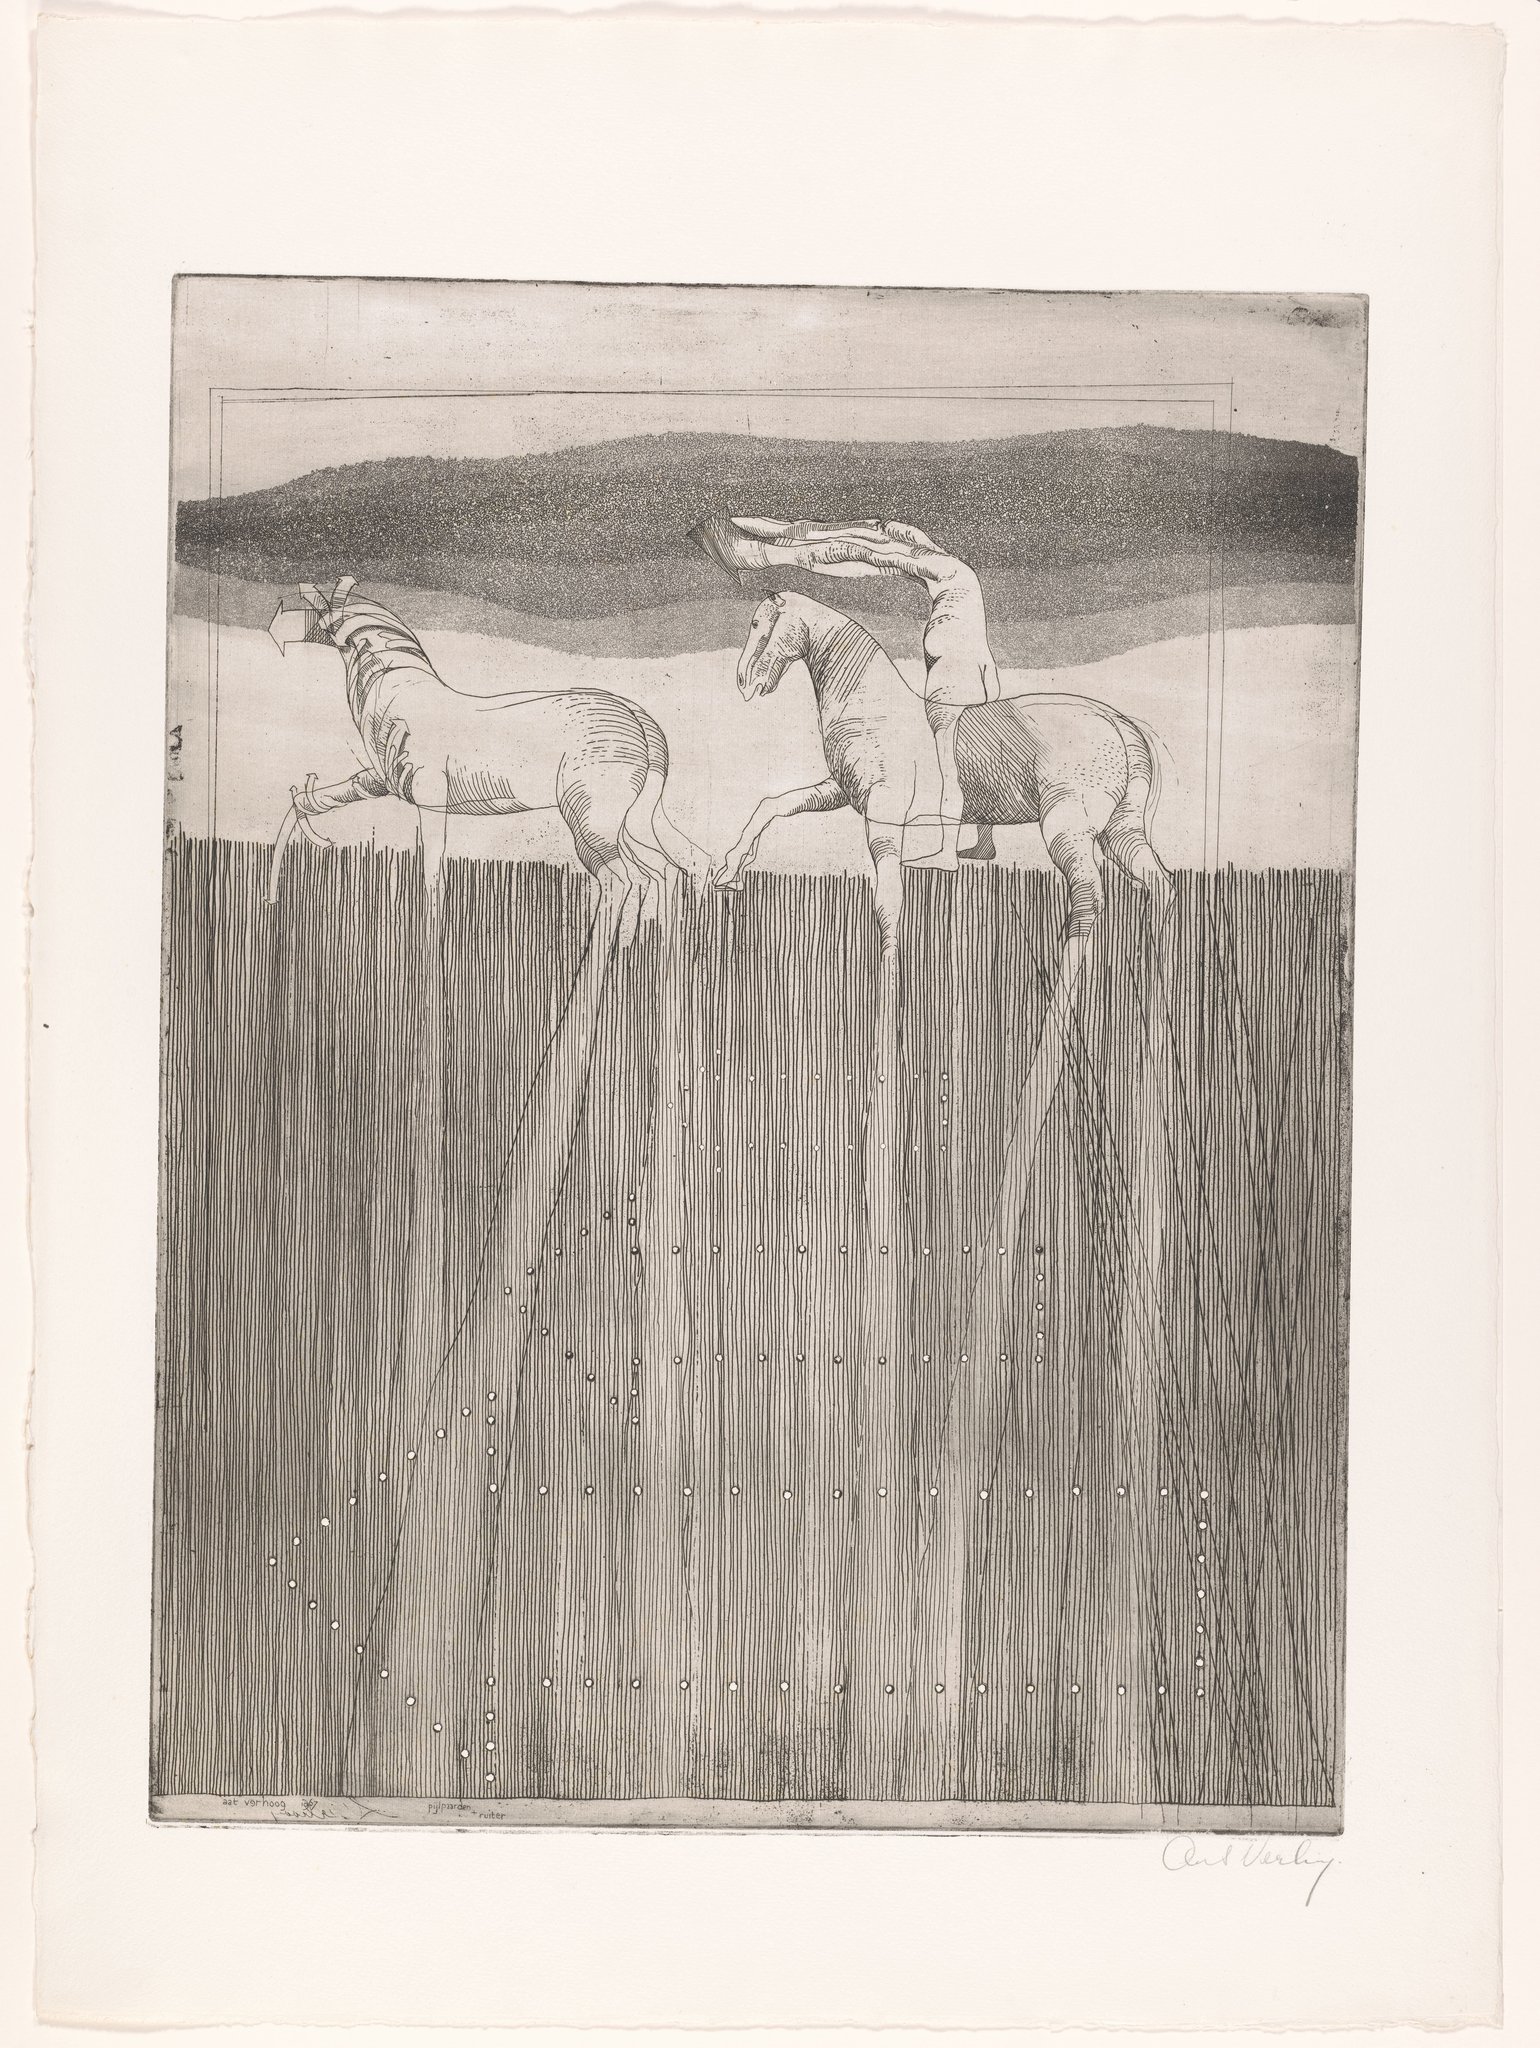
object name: print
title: Pijlpaarden plus ruiter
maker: aat verhoog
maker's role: print maker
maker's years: 1933-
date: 1967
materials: paper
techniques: etching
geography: netherlands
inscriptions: title: ‘pijlpaarden + ruiter’, signature and date: ‘aat verhoog 1967’, signature: ‘Aat Verhoog’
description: Twee paarden met hun benen diep in de grond geworteld, de voorste met pijlen om zijn hals, hoofd en voorbeen gewikkeld, de achterste met ruiter.